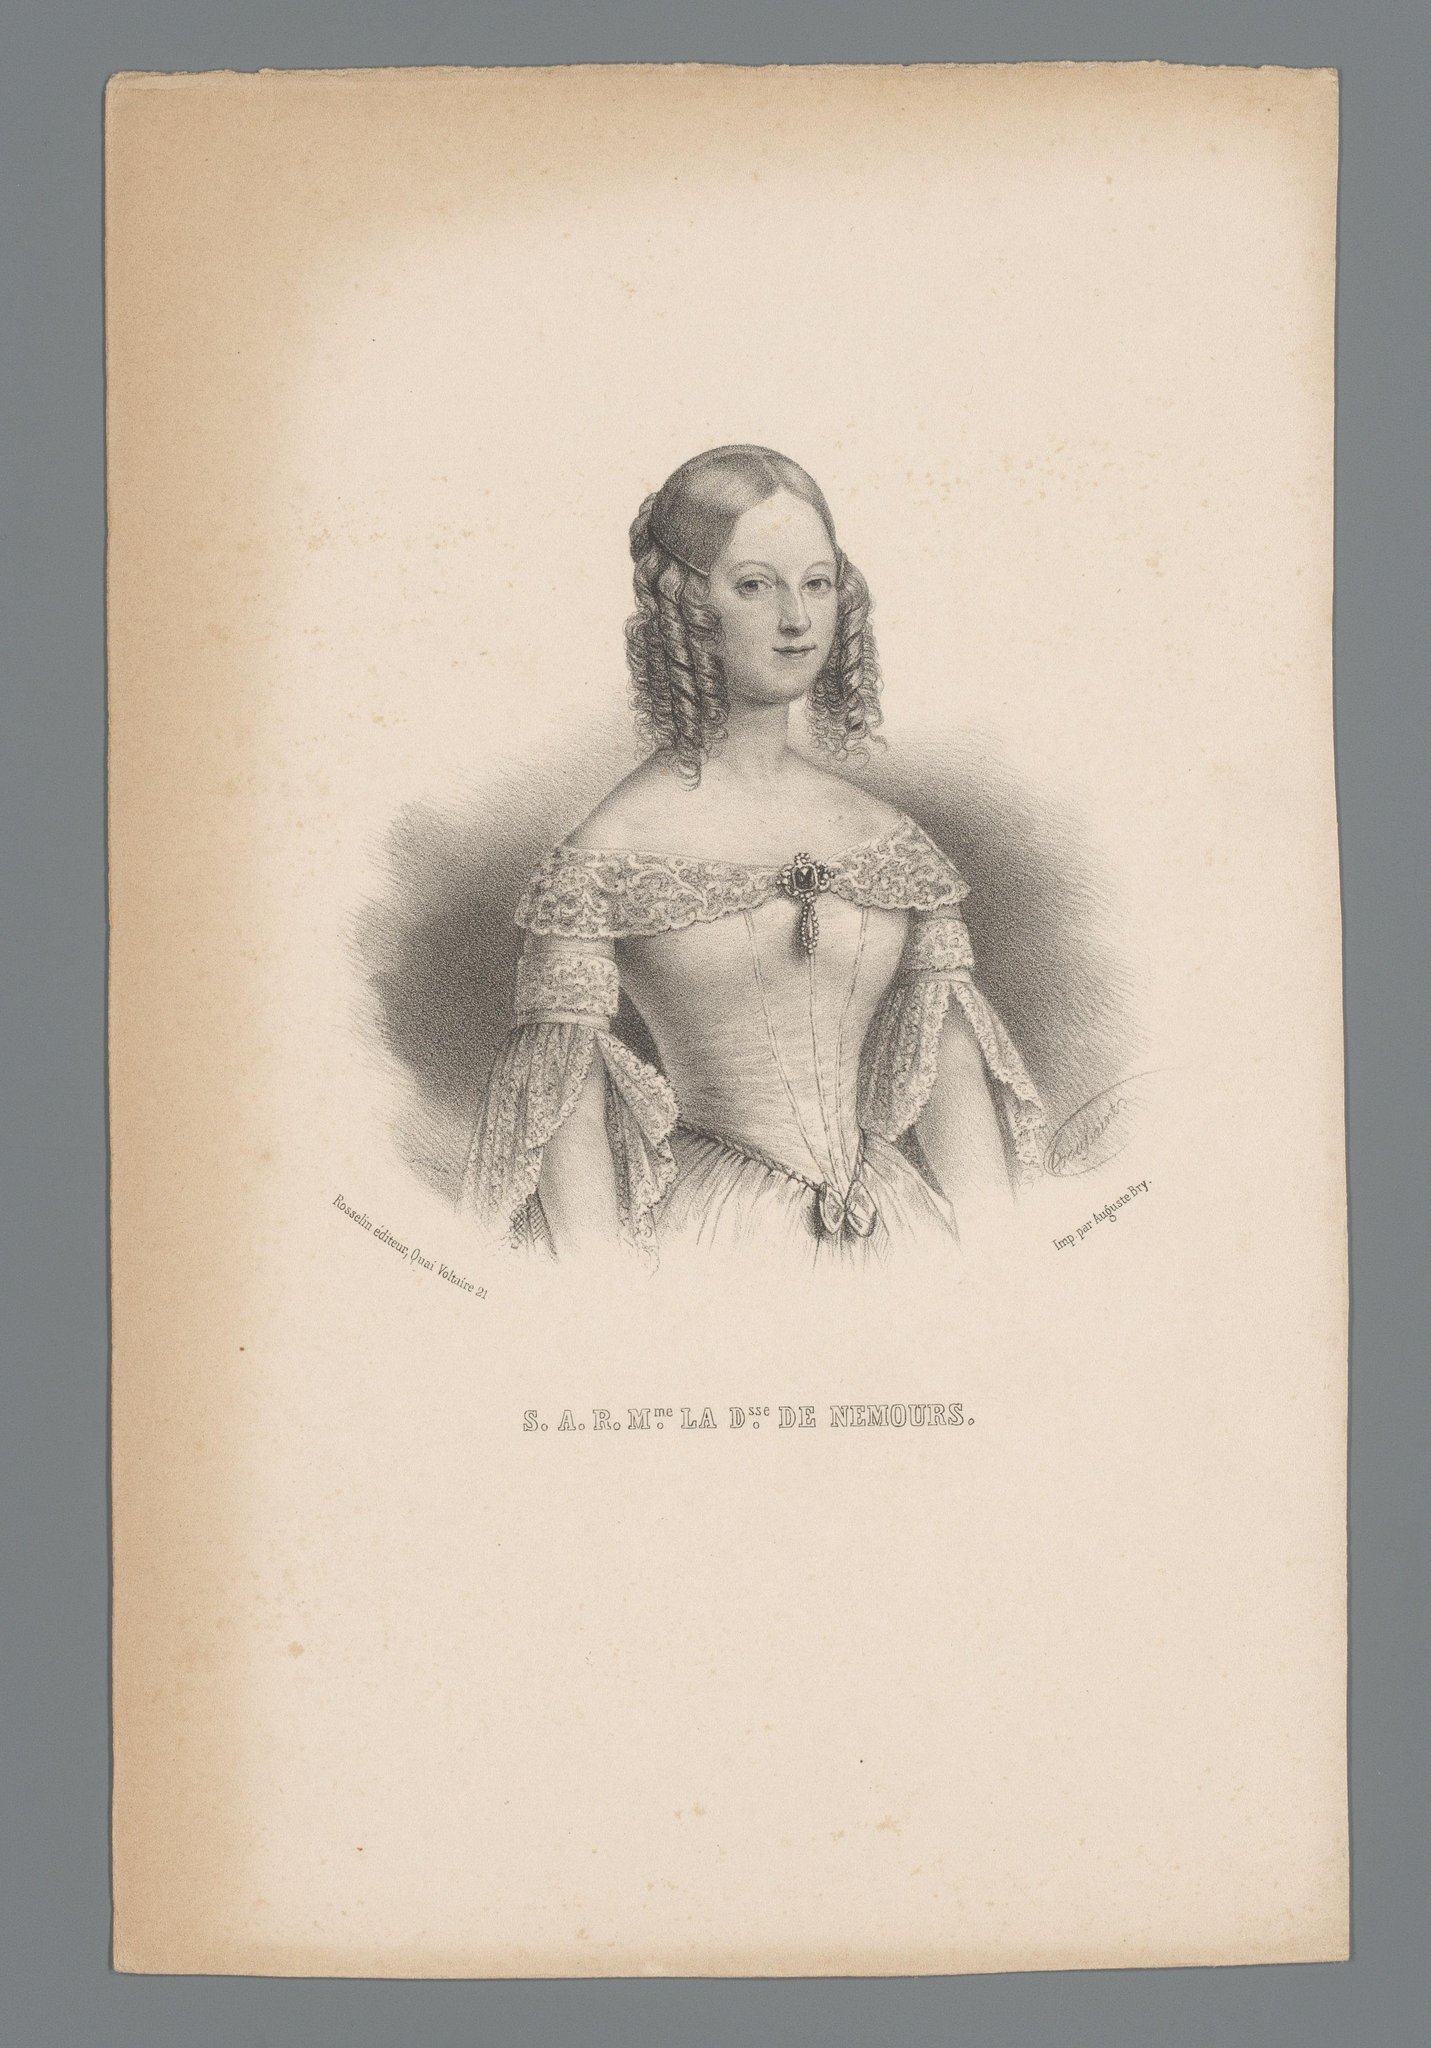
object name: print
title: Portret van prinses Victoria van Saksen-Coburg en Gotha, hertogin van Nemours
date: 1846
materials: paper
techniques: lithograph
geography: paris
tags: vienna, politician, historical persons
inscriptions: collector's mark: Lugt 2228